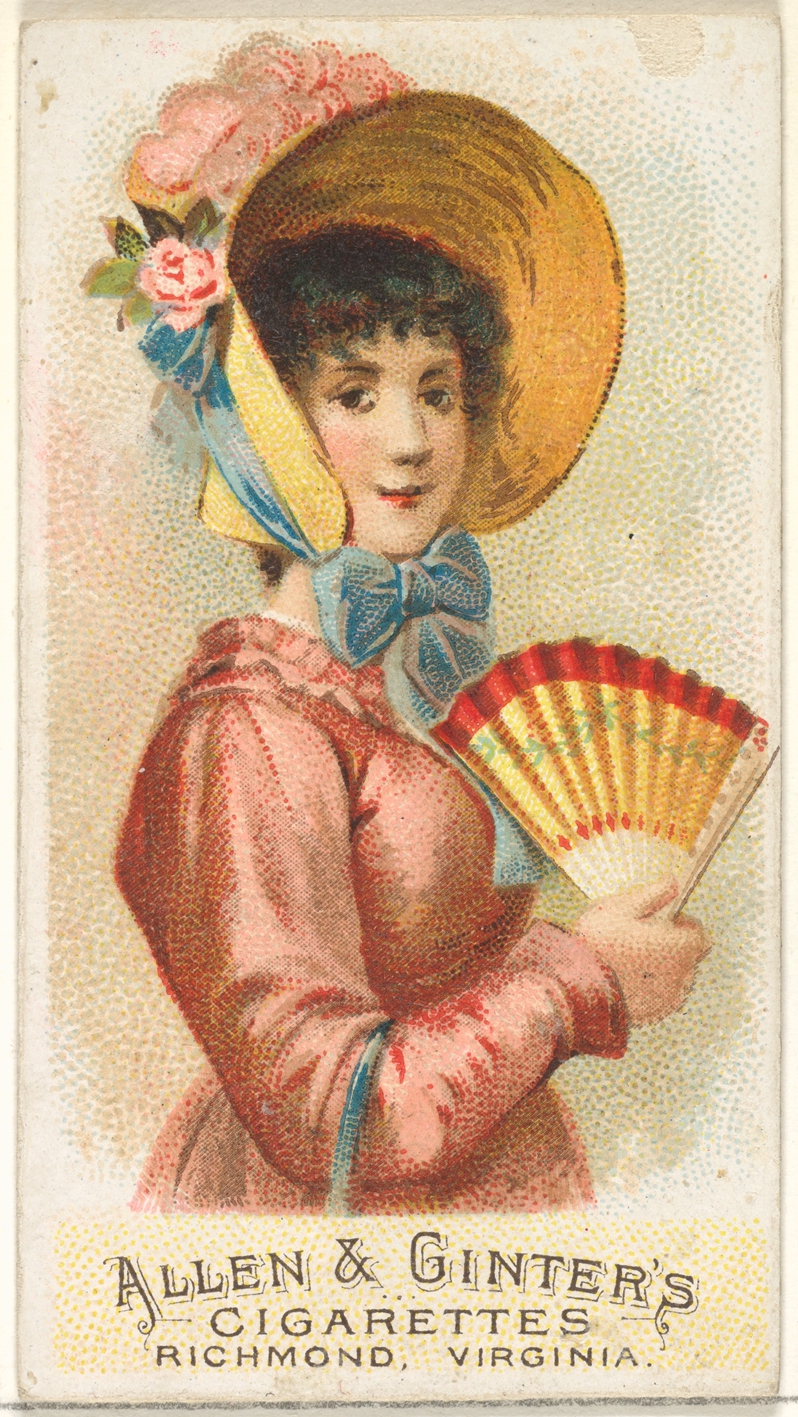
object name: print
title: Plate 2, from the Fans of the Period series (N7) for Allen & Ginter Cigarettes Brands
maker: allen & ginter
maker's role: publisher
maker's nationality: american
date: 1889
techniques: color lithograph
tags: fans,women